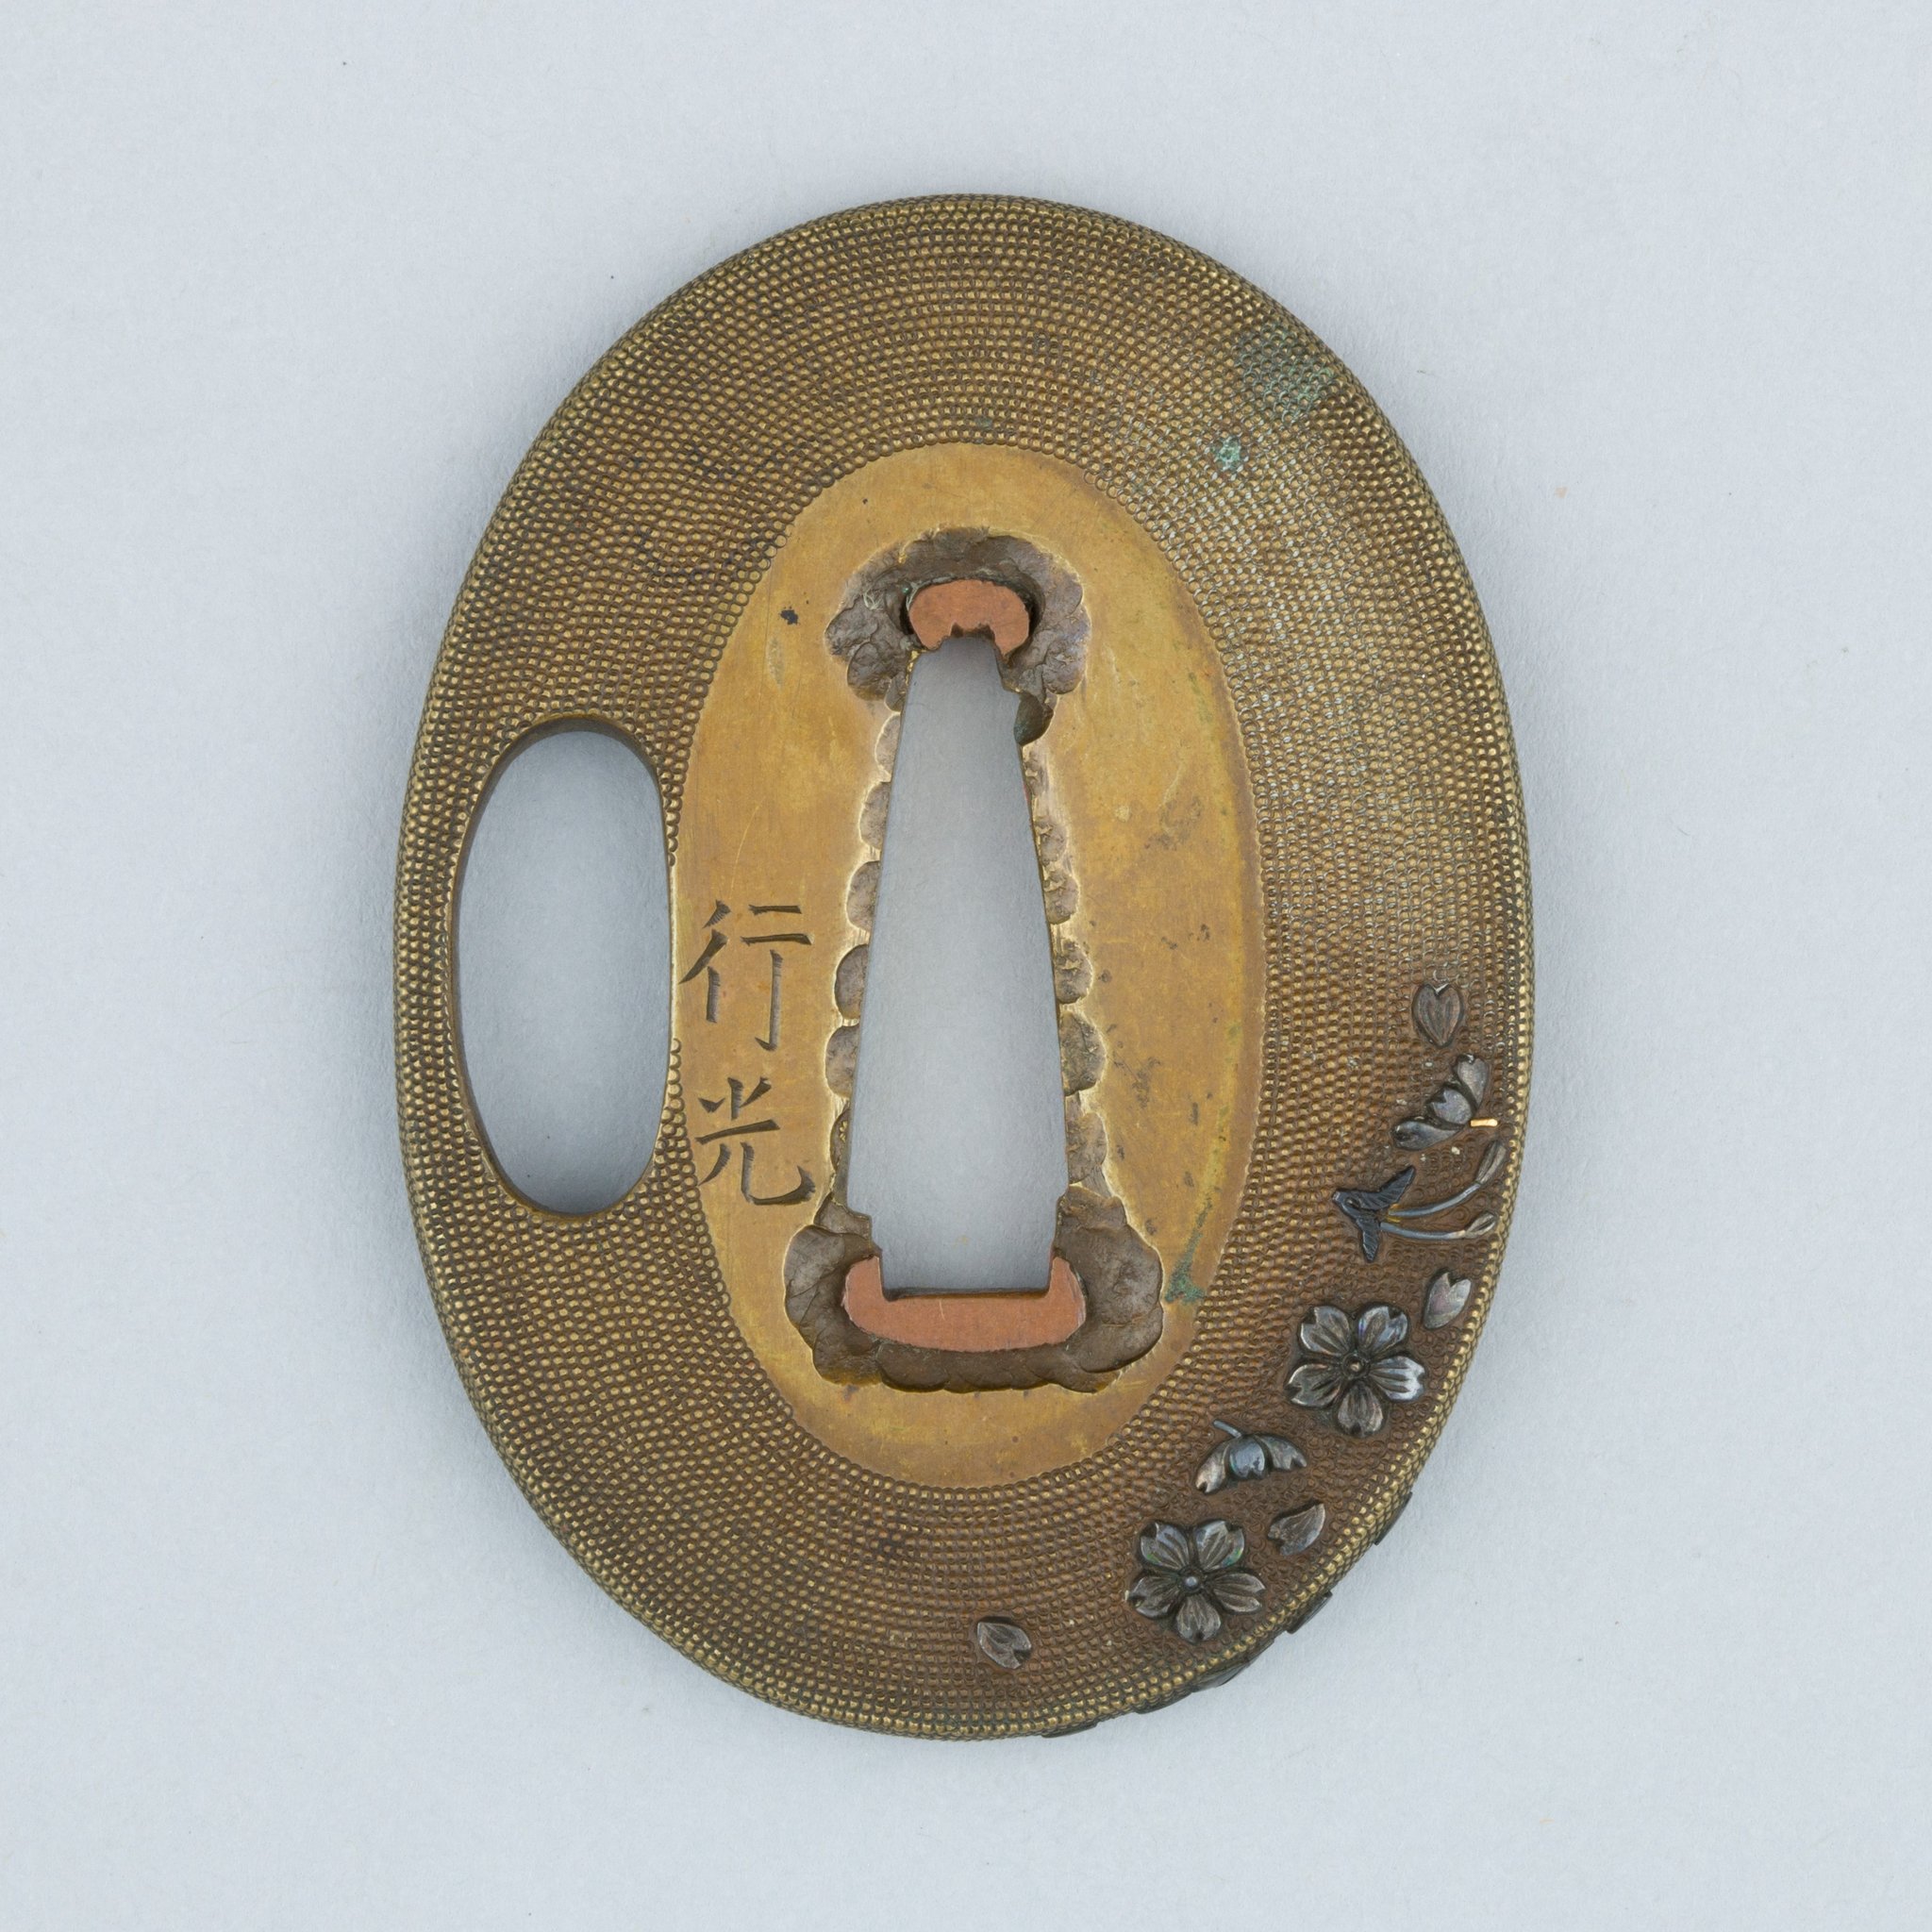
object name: sword guard tsuba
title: Sword Guard (Tsuba)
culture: japanese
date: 1615-1868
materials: copper, copper alloy, silver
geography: japan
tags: flowers